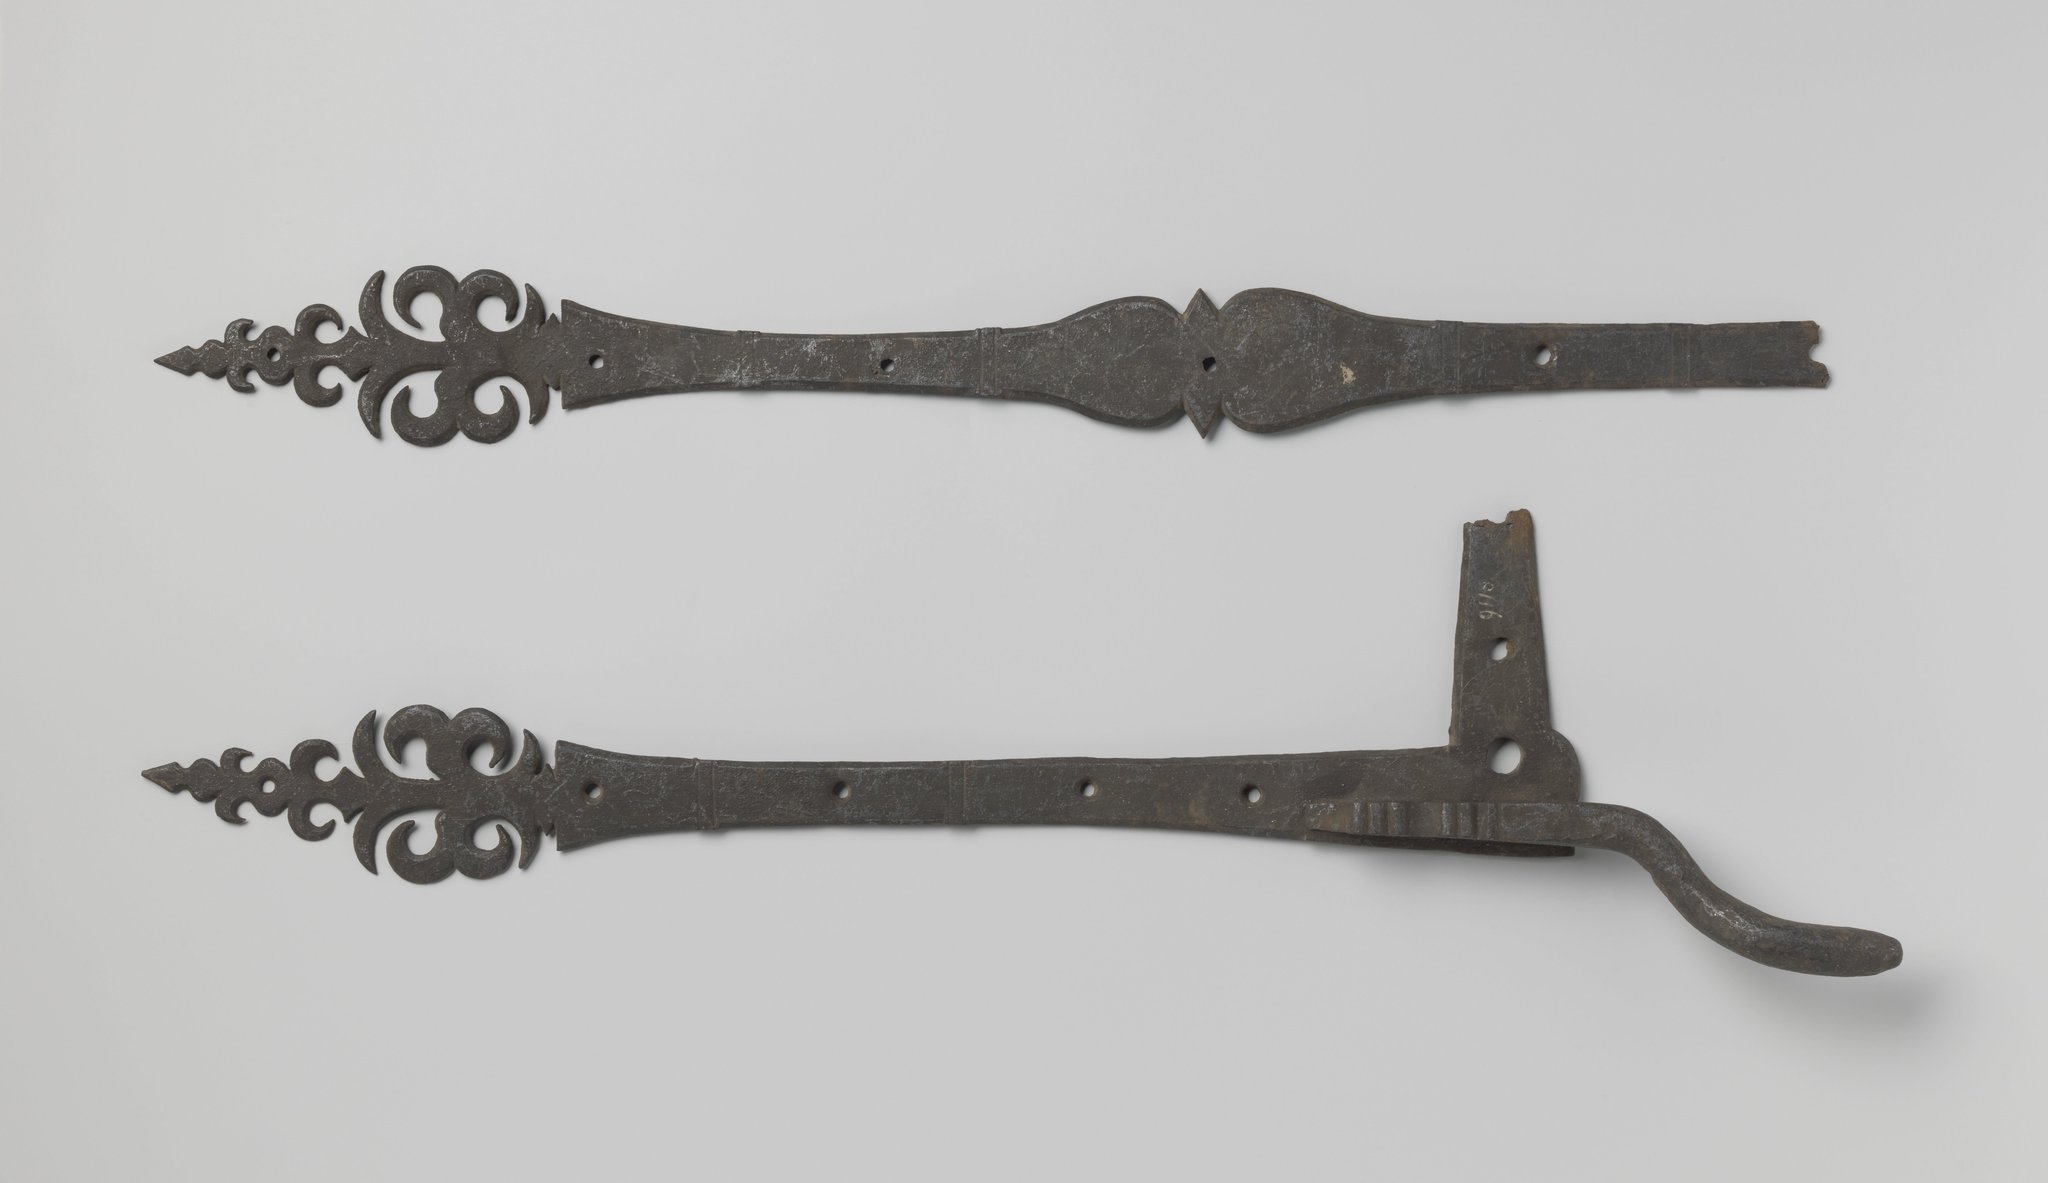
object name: hengsel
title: Hengsel van vertind ijzer met speun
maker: Anonymous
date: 1600-1800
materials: iron, tin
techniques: tinning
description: Hengsel van vertind ijzer met een speun op de hoek. Vanaf de hoek lopen twee lange benen, waarvan een met een nodus, uitmondend in een opengewerkte punt met voluten en krullen.